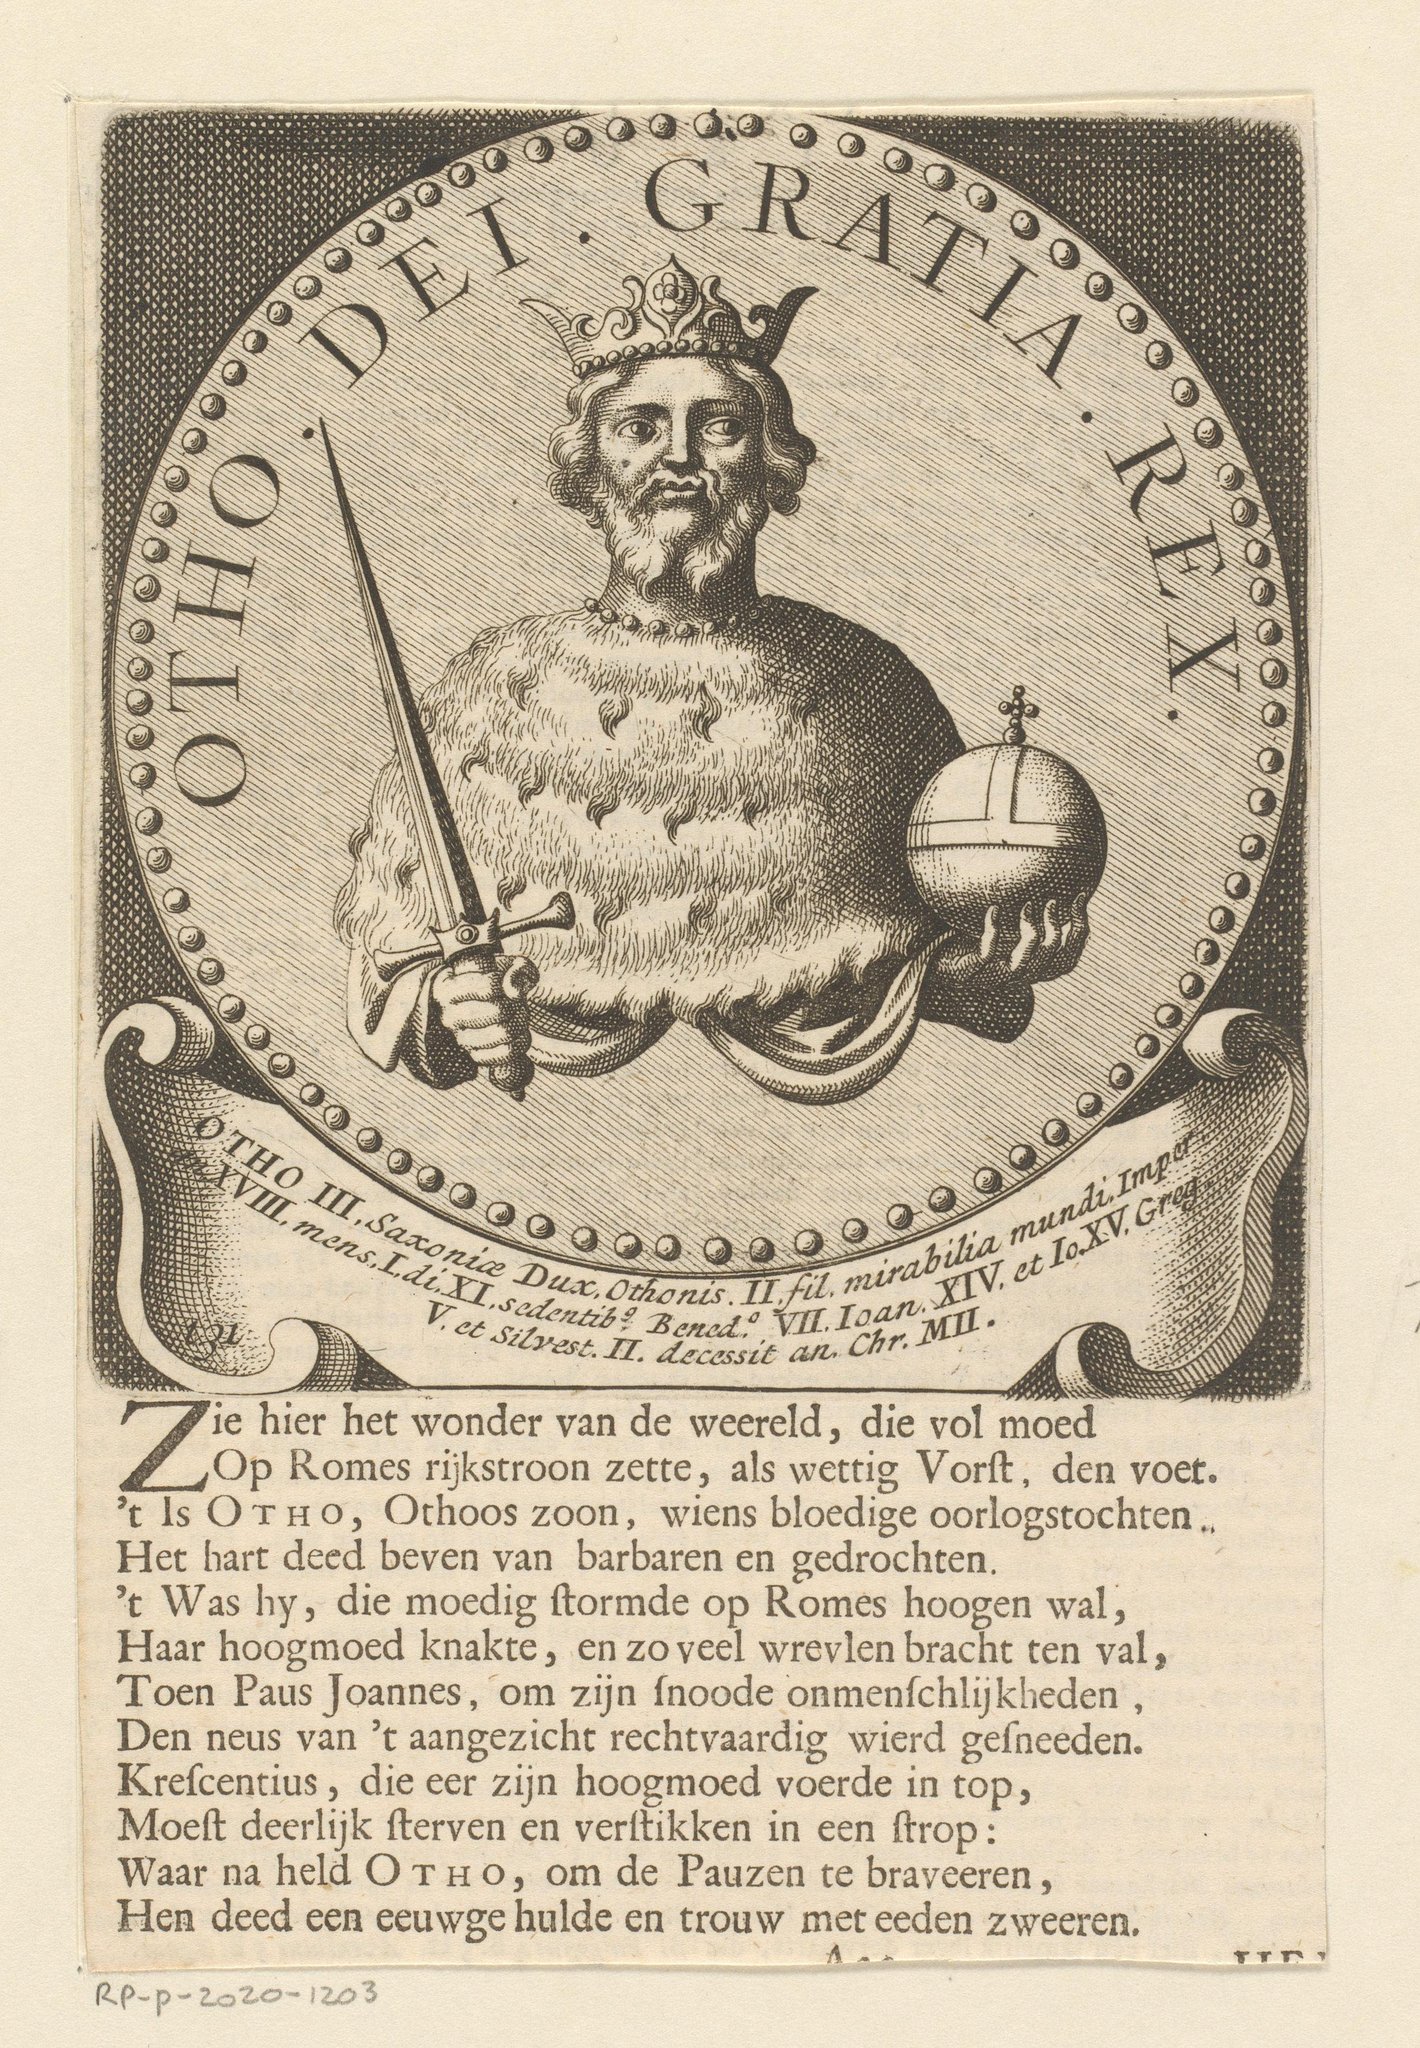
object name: print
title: Portret van keizer Otto III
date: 1697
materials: paper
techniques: engraving, etching, letterpress printing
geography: utrecht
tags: crown (symbol of sovereignty), historical persons, hacking and thrusting weapons: sword, emperor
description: Prent uit: Bogaert, Abraham. De Roomsche monarchy, vertoont in de muntbeelden der westersche en oostersche keizeren (...). Utrecht: François Halma en Willem van de Water, 1697, p. 369. Eerste staat verschenen als grotere prent met 12 portretten, gedateerd 1695.